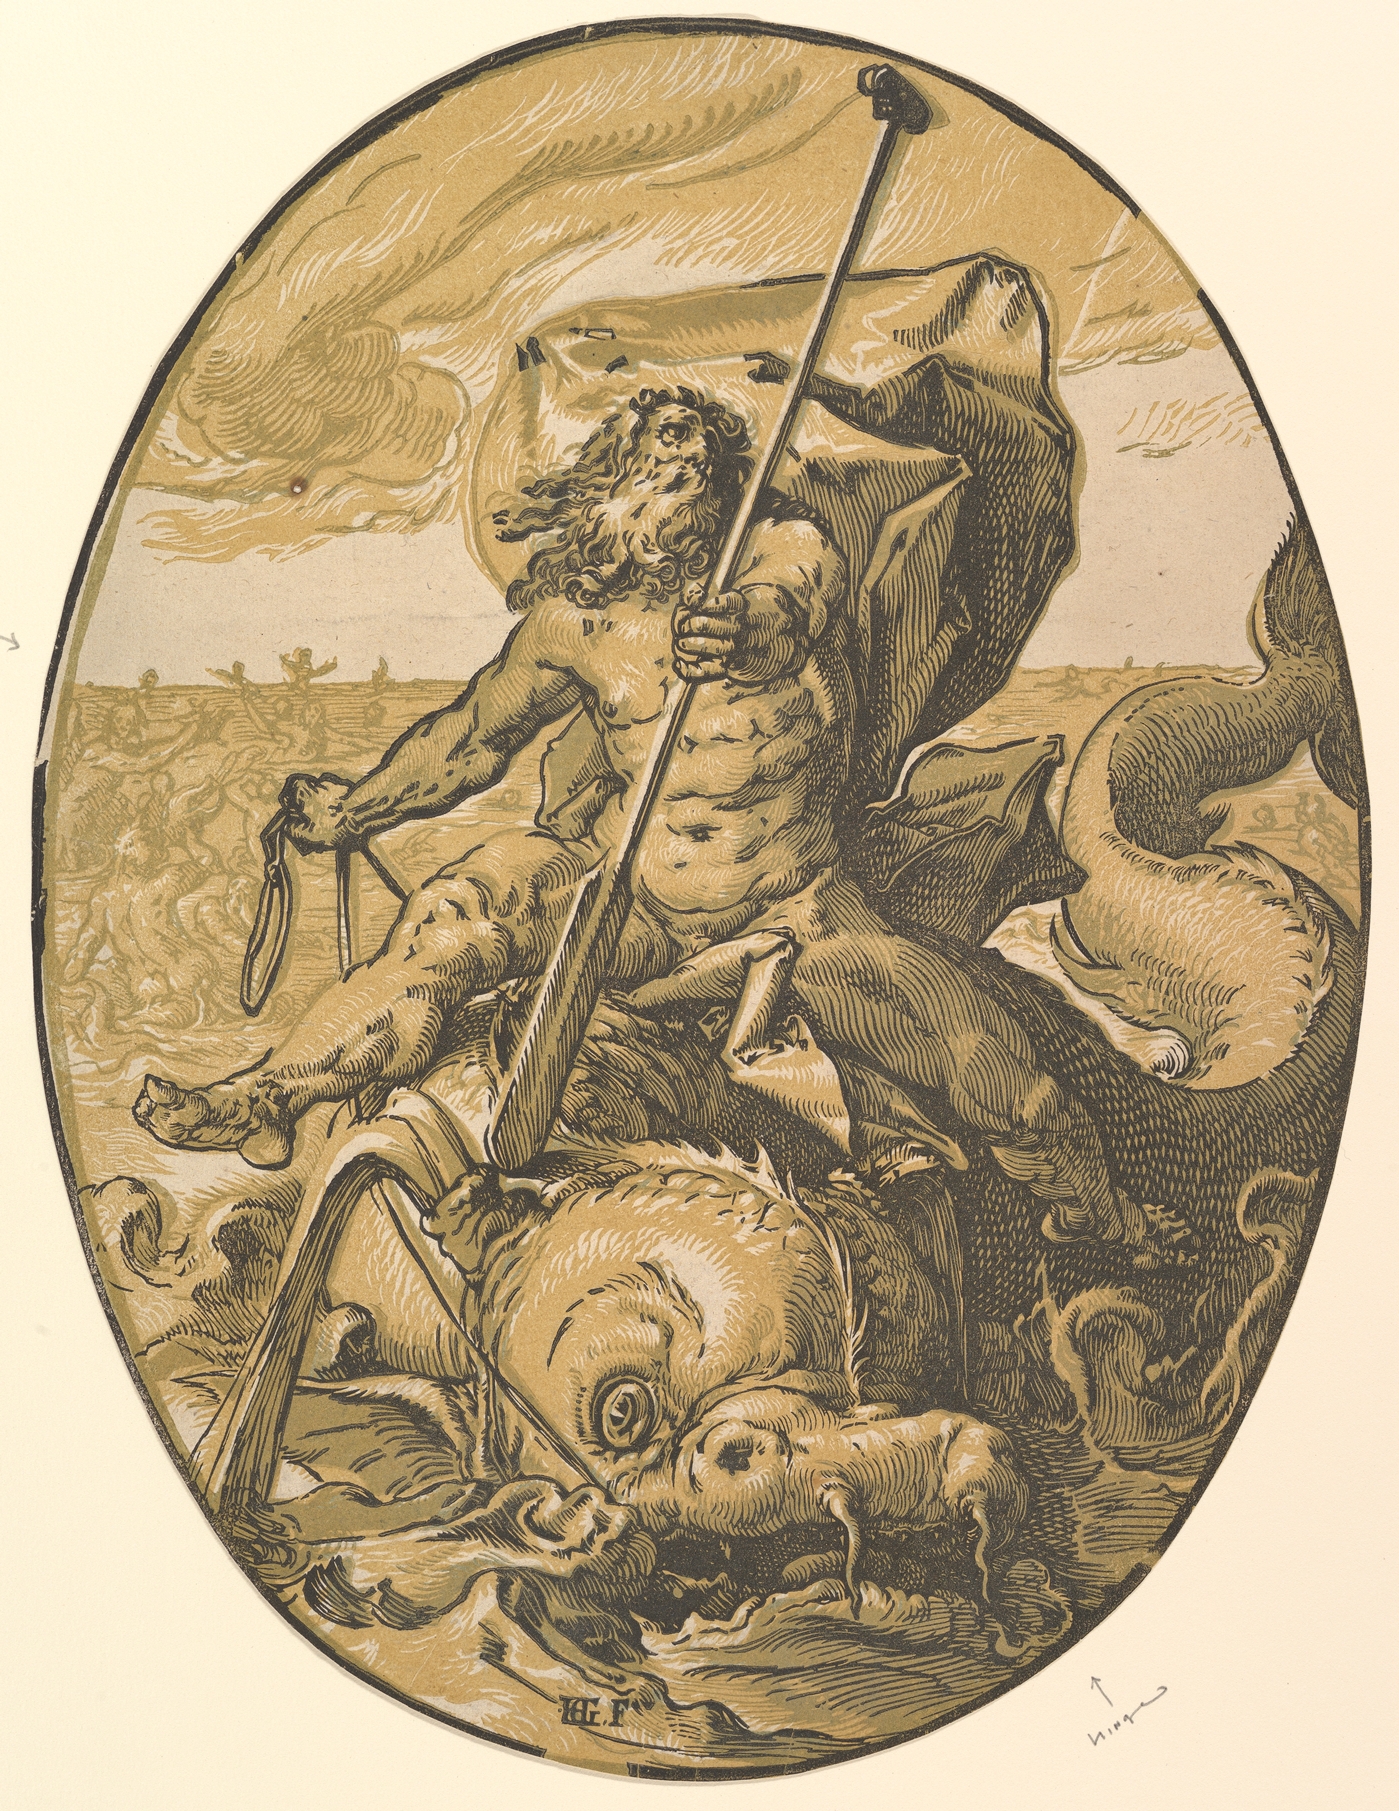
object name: print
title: Oceanus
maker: hendrick goltzius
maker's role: artist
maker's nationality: netherlandish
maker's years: 1558-1617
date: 1589-1590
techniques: woodcut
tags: men,mythical creatures,fish